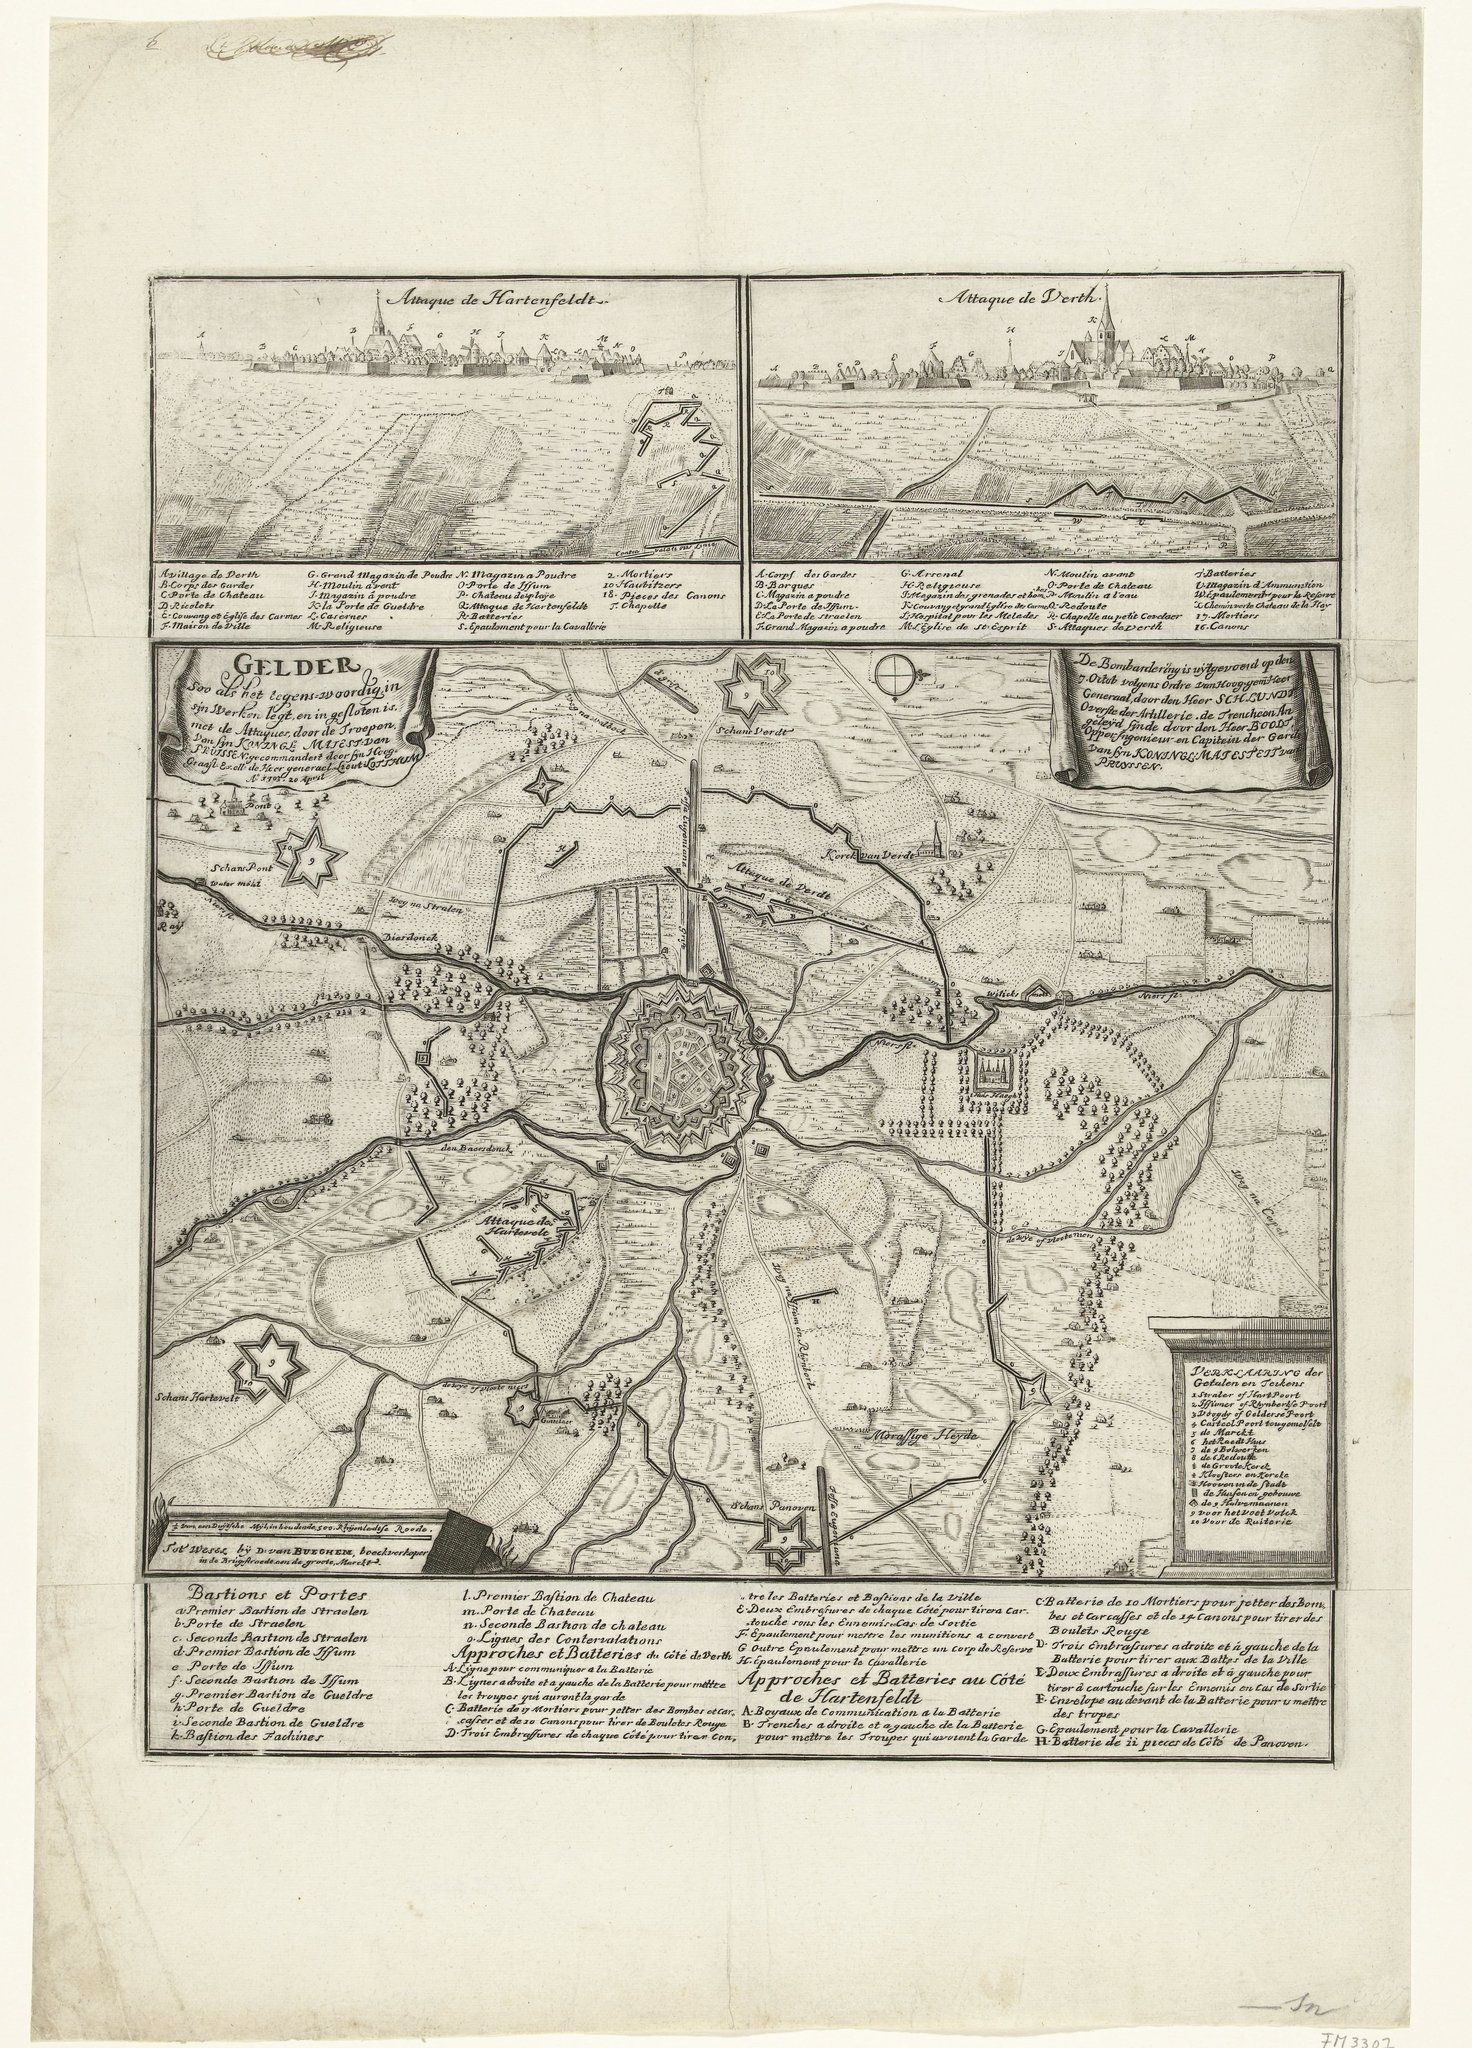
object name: map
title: Gelder soo als het tegens-woordig, in syn werken legt, en ingesloten is, met de Attaques, door de Troepen van syn Koningl. Majest. van Pruissen, gecommandert door syn Hoog. Graafl. Excell. de Heer generael Lieut. Lotthum Ao. 1703, 20 April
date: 1703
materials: paper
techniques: engraving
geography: wesel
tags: siege, position war, maps of cities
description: Kaart van Geldern en omgeving, tijdens het beleg door de Pruisische troepen onder generaal Lotthum op 20 april en het bombardement op 7 oktober 1703. Bovenaan en onderaan zijn stroken vastgeplakt met gezichten op de stad vanuit Hartenfeldt en Verth en de verklaringen in het Frans.